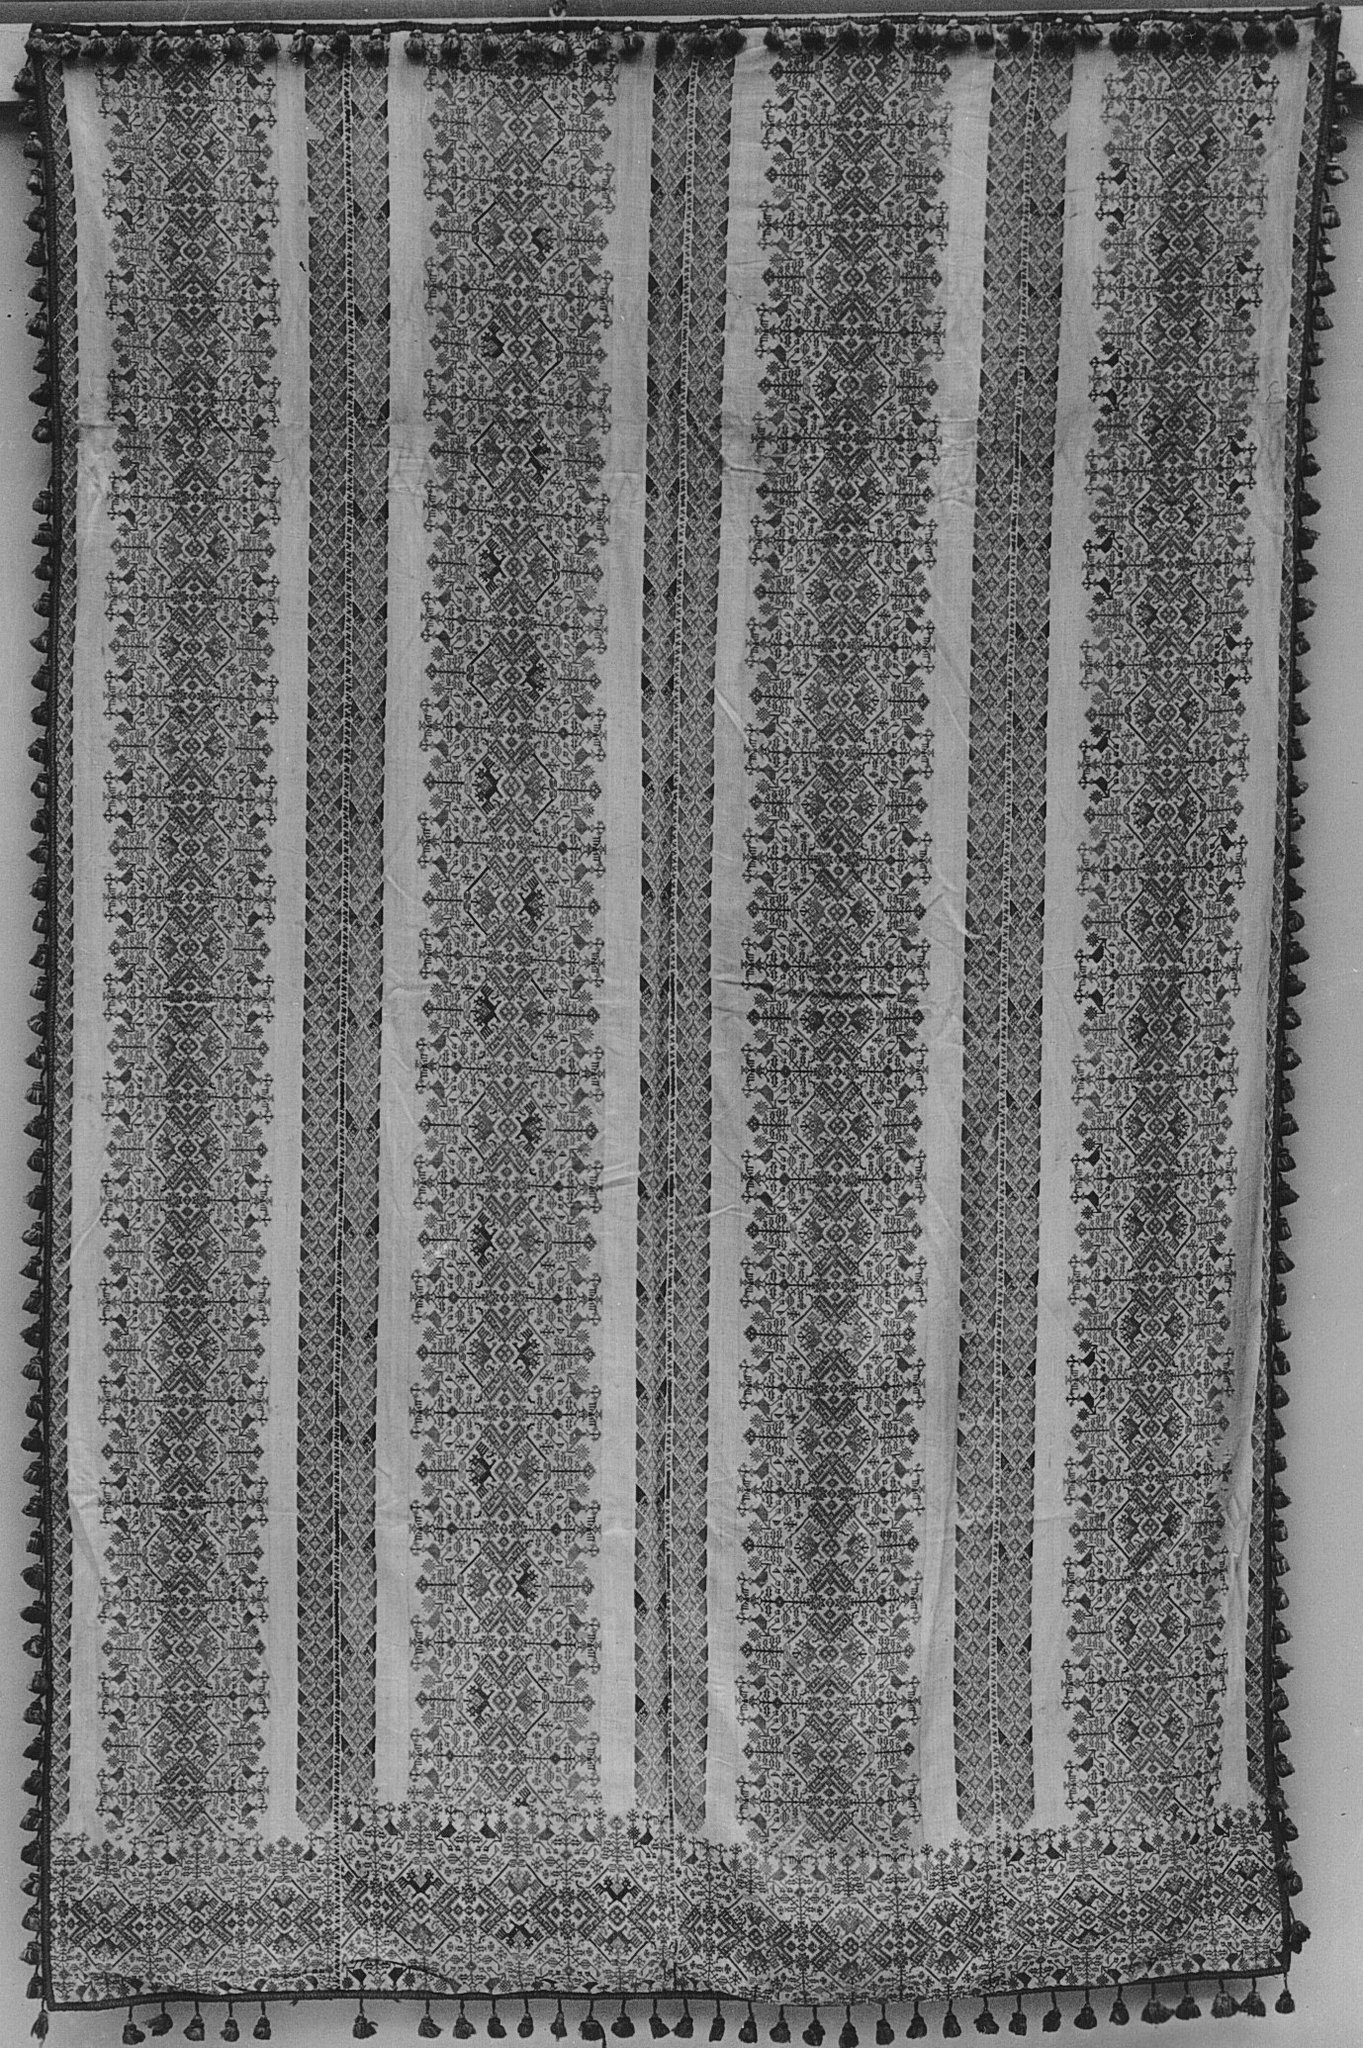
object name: bed curtain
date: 1701-1800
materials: linen